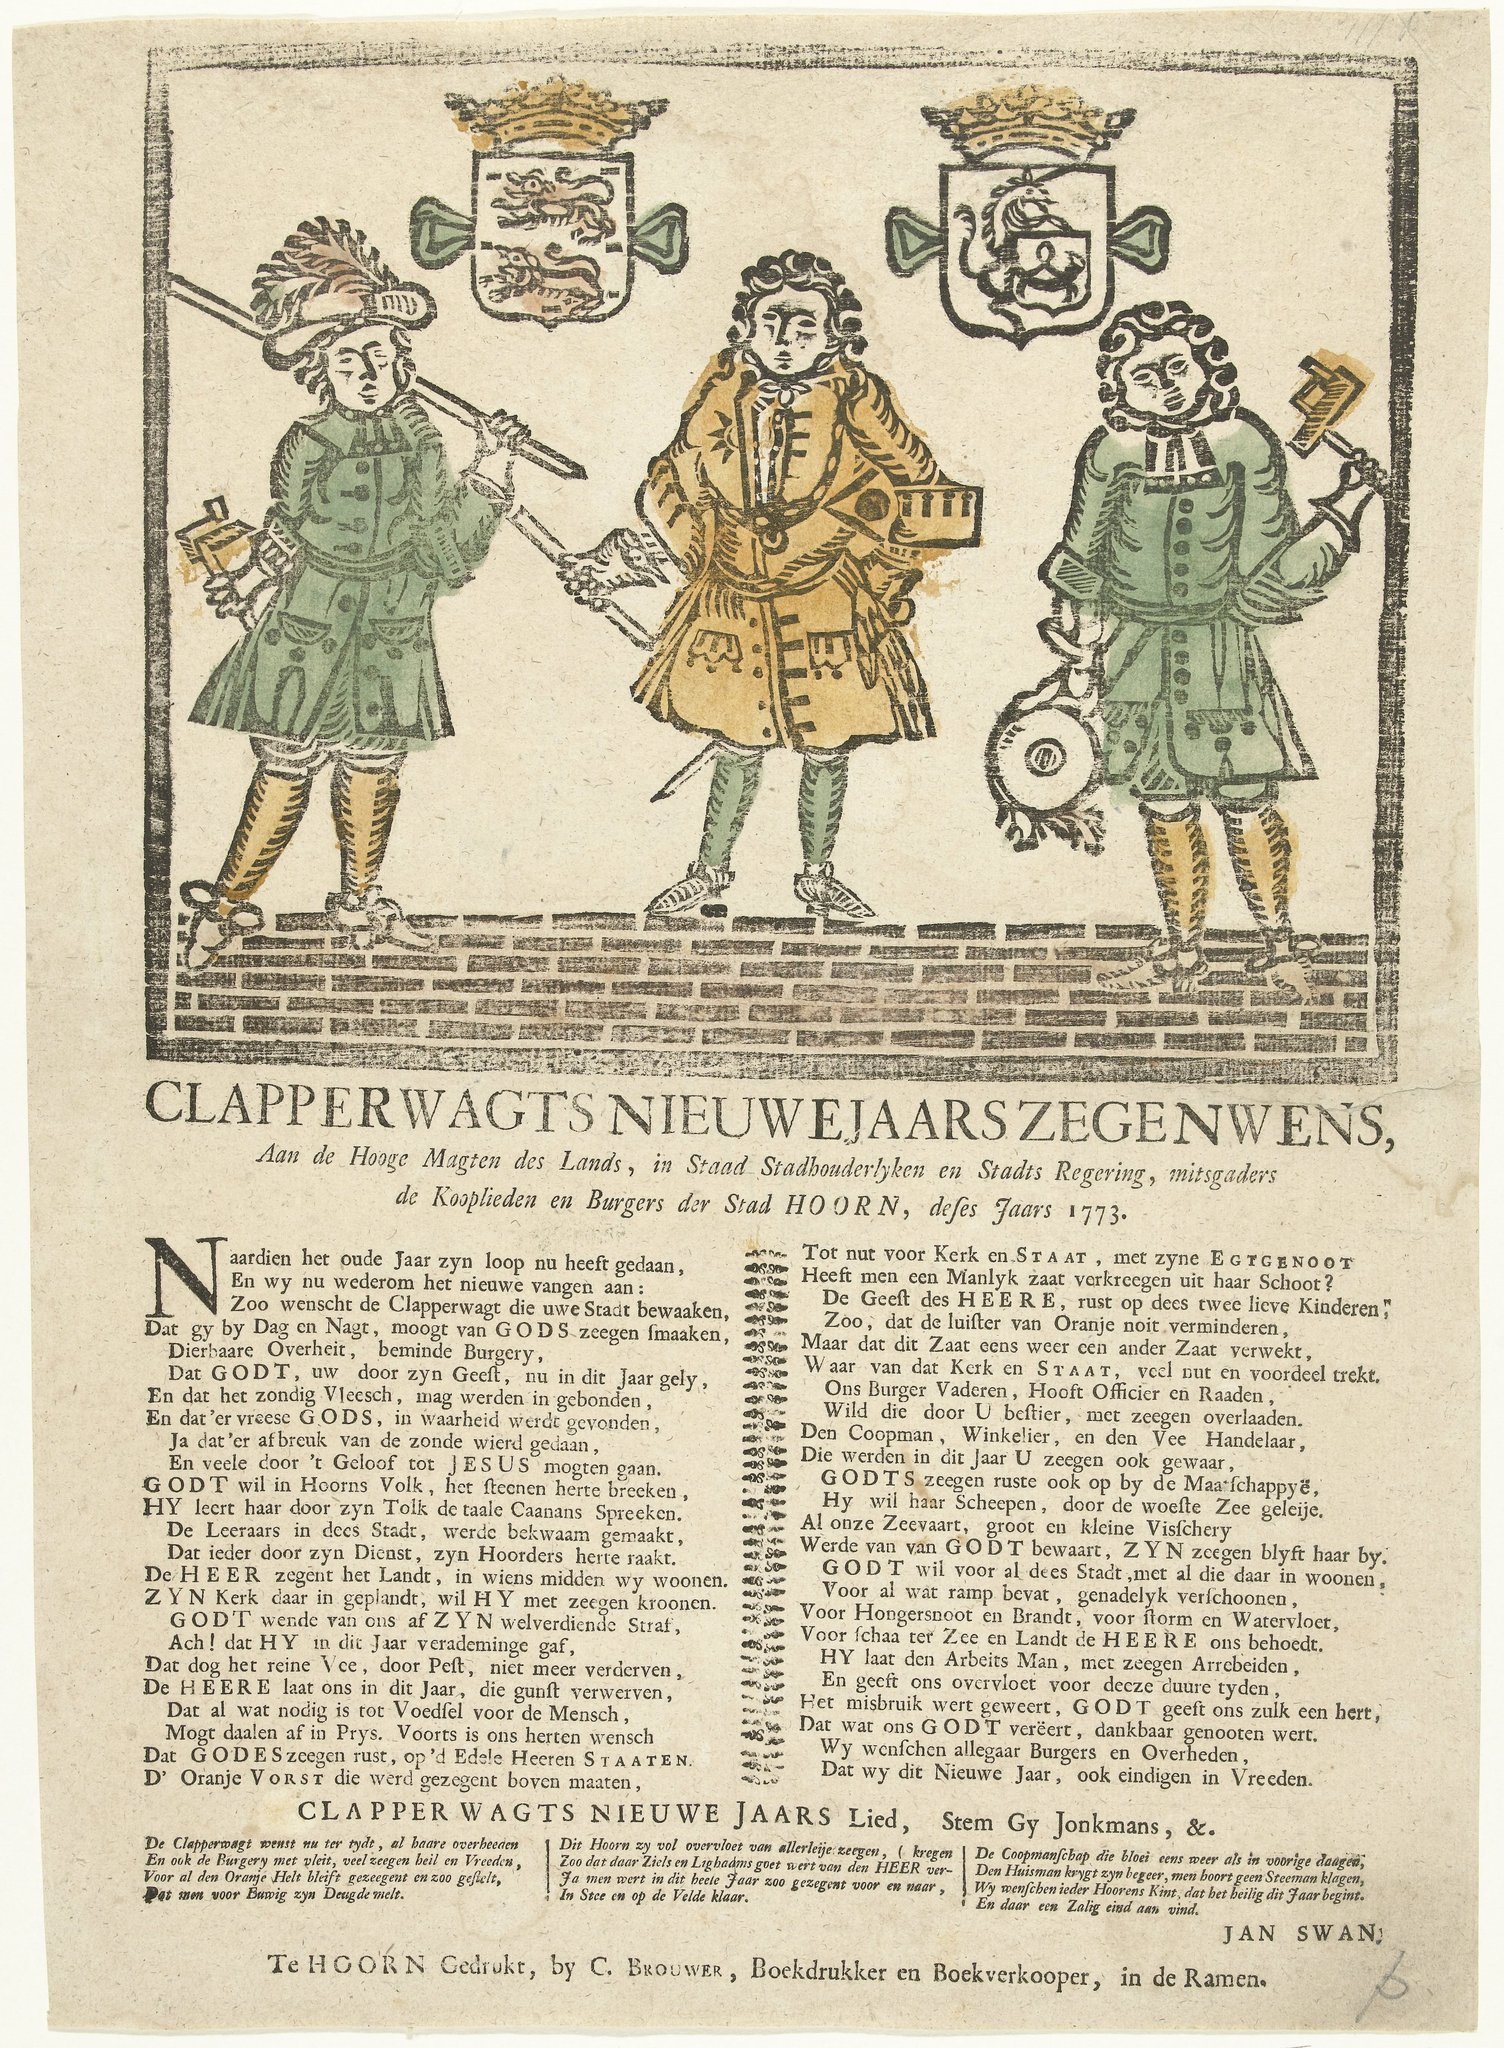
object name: popular print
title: Clapperwagts Nieuwejaars Zegenwens, Aan de Hooge Magten des Lands, in Staad Stadhouderlyken en Stadt Regering, mitsgaders de Kooplieden en Burgers der Stad Hoorn, deses Jaars 1773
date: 1772-1773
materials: paper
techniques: hand coloring, letterpress printing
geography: hoorn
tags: night patrol, hoorn (north holland)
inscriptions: collector's mark: Lugt 2228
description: Nieuwjaarsprent van de klapperwacht (ratelwacht of nachtwacht) van de stad Hoorn voor het jaar 1773. Opgedragen aan de bestuurders en inwoners van Hoorn. Twee leden van de wacht met een officier, met de wapens van West-Friesland en Hoorn. Op het blad onder de voorstelling een vers in twee kolommen met onderaan een lied in drie kolommen van Jan Swan.